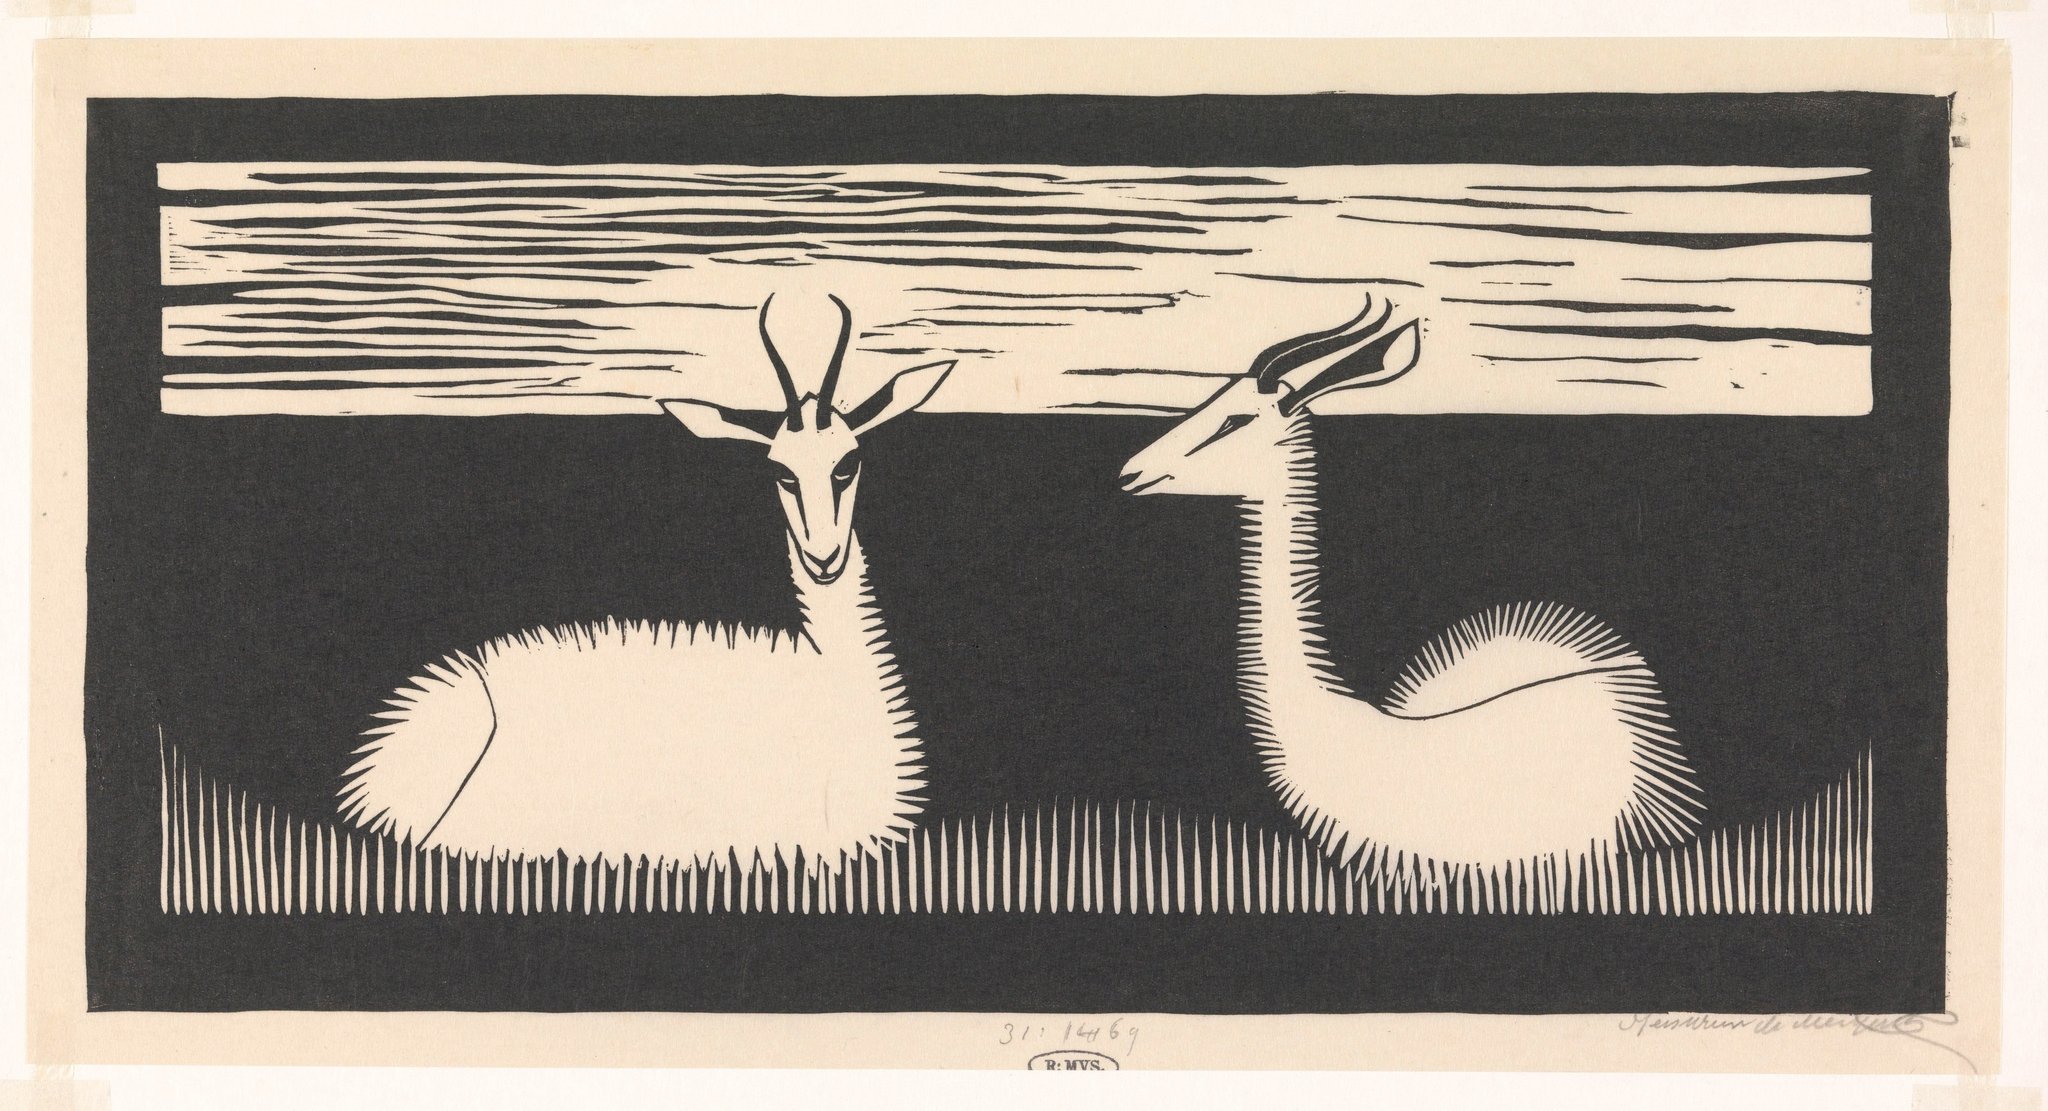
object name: print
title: Gazellen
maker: samuel jessurun de mesquita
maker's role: draughtsman, print maker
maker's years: 1868-1944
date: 1926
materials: paper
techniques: woodcut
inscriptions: signature: ‘Jessurun de mesquita’